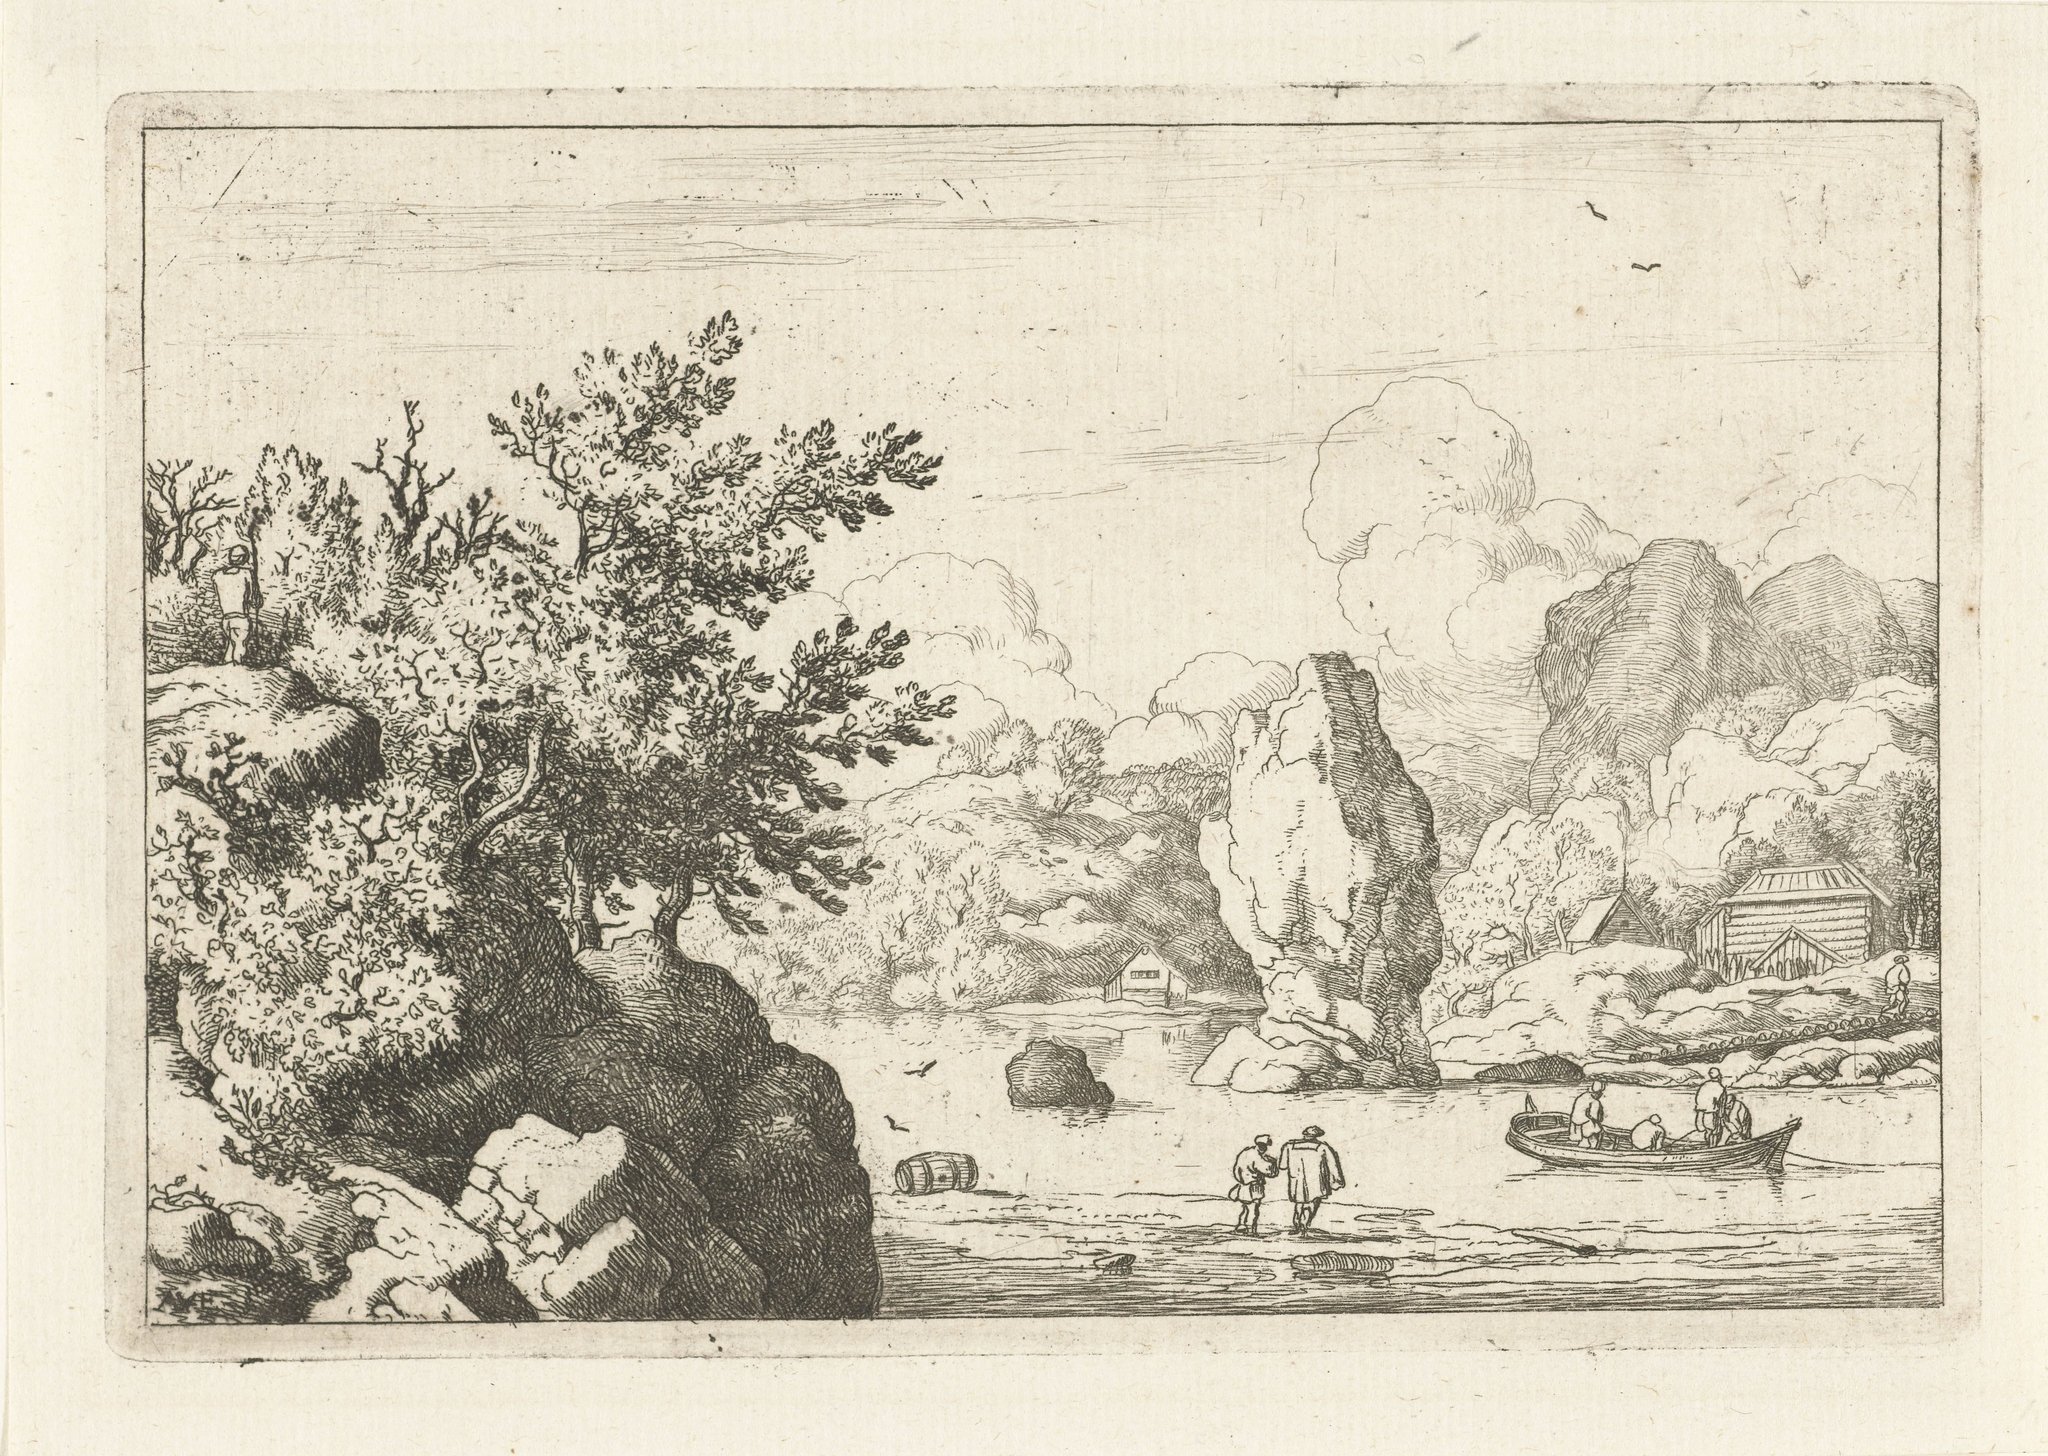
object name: print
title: Een rots in een rivier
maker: allaert van everdingen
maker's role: draughtsman, painter, print maker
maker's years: 1621-1675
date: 1631-1675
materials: paper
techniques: etching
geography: netherlands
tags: river (+ landscape with figures, staffage)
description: Berglandschap met op de voorgrond een man op een hoge rotspartij. Op het water een roeiboot met vier personen en langs de kant twee toeschouwers.